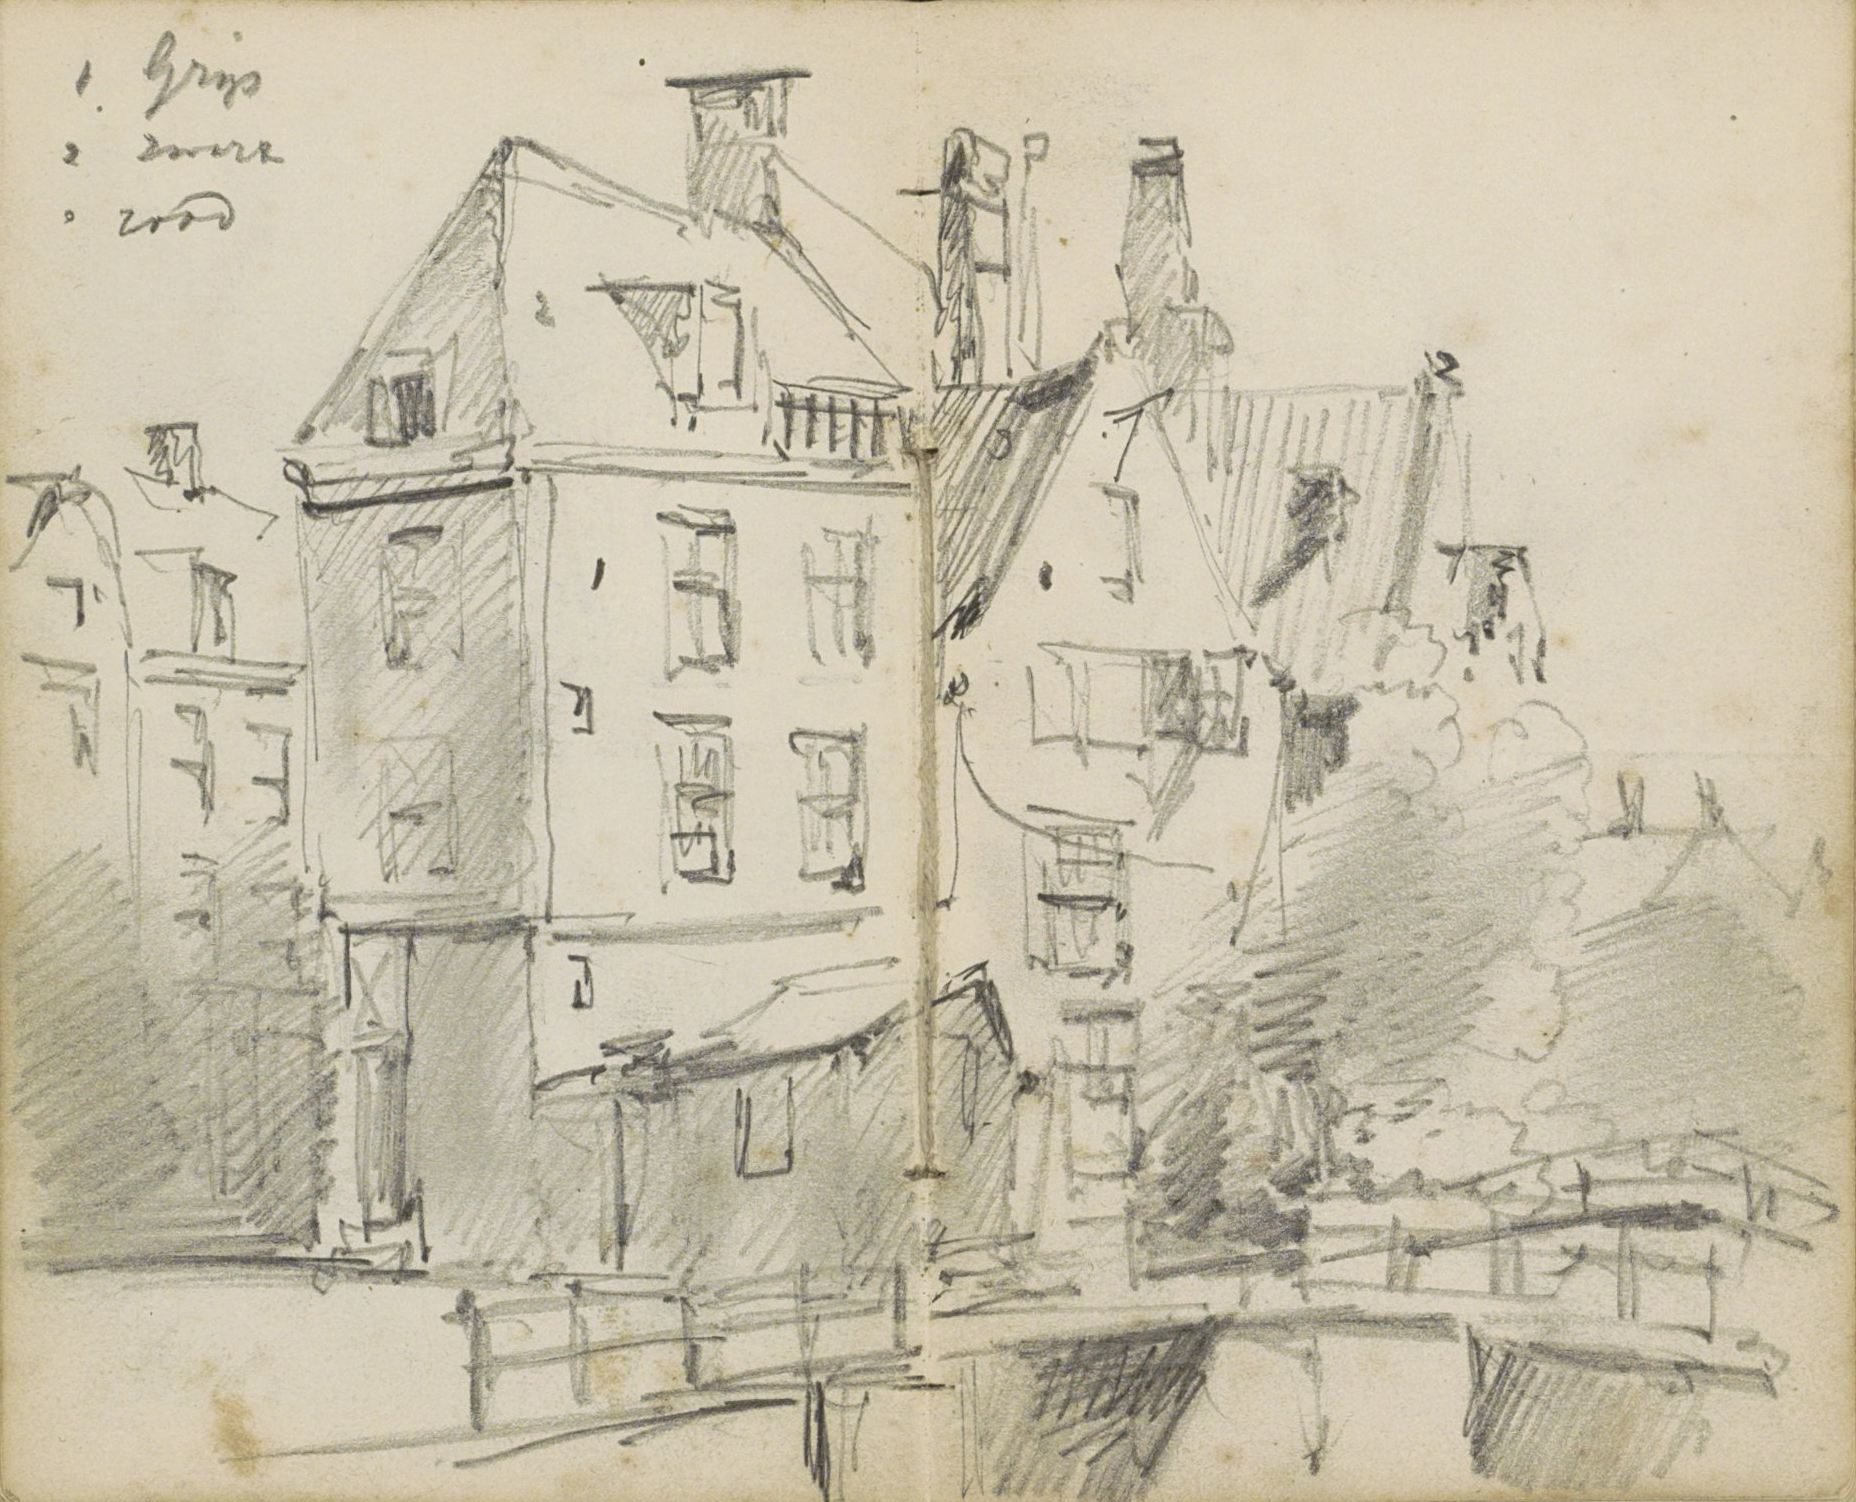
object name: sketchbook leaf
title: Stadsgezicht met een brug over een gracht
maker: willem koekkoek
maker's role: draughtsman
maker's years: 1839-1895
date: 1849-1895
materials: paper, pencil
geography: amsterdam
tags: canals, waters (in city)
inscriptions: kleurnotitie, handgeschreven in potlood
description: Blad 43 verso 44 recto uit een schetsboek met 57 bladen.